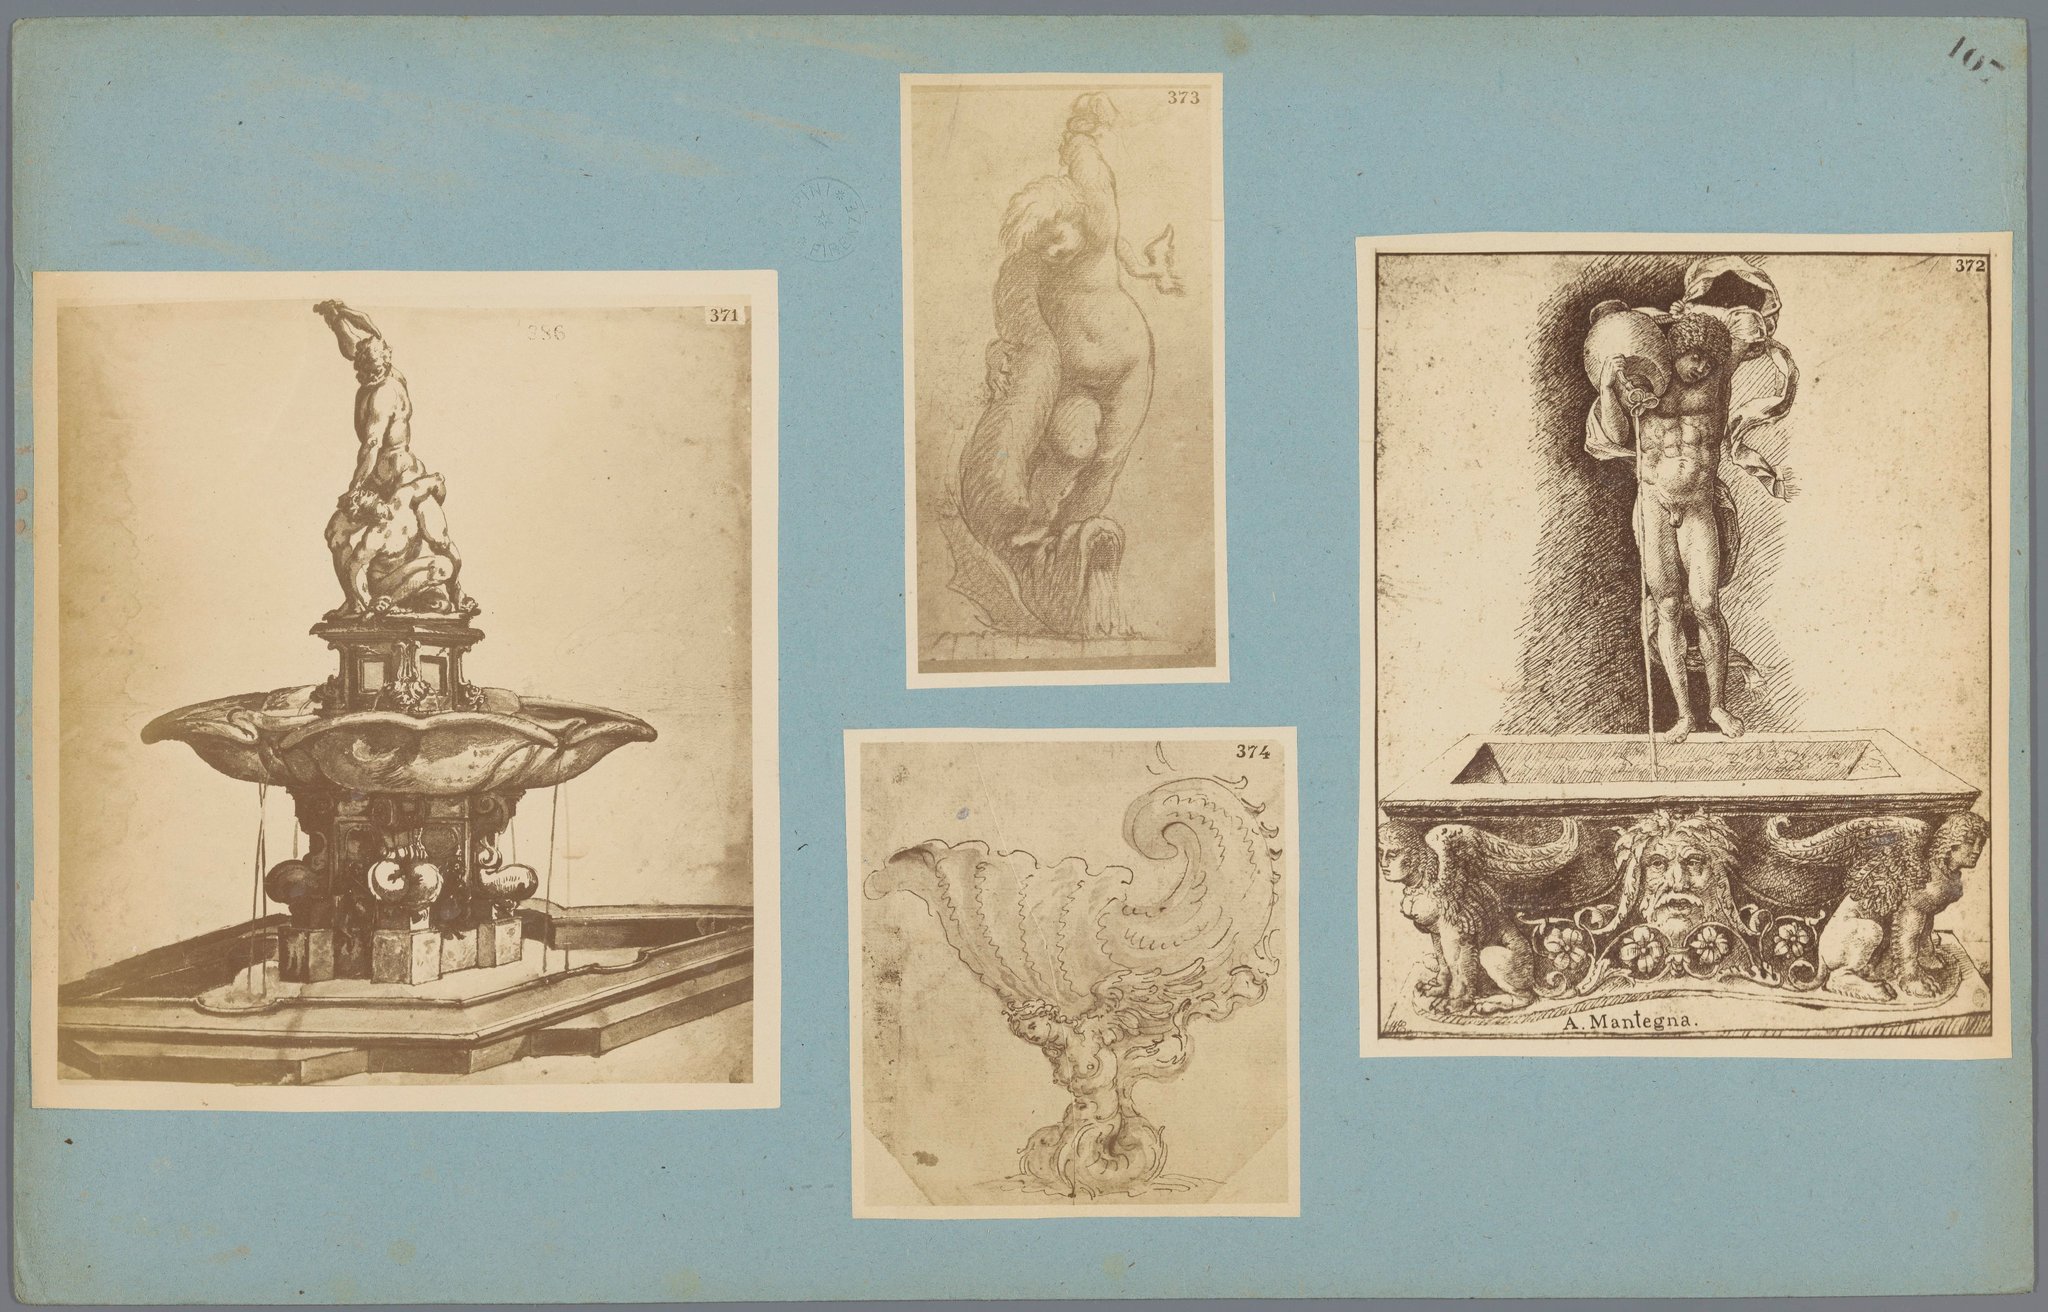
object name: photograph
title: Vier fotoreproducties van tekeningen van fonteinen en een schaal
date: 1875-1900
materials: cardboard, photographic support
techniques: albumen print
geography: europe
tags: drawing, sketch, fishes, scallop, shell ~ ornament, ornamental fountain, dish, plate, saucer, europe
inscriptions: number: ‘386’, collector's mark: Lugt 3937, number: ‘107’, number: ‘371’, number: ‘374’, number: ‘372’, name: ‘C. Pini Firenze’, number: ‘373’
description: Links (371) een fontein met een man in een aanvallende houding tegenover iemand onder hem, midden boven (373) een fontein met een kind en een vis, midden onder (374) een schaal in de vorm van een schelp ondersteund door een vrouwenfiguur, rechts (372) een fontein met een man die een waterkruik draagt door Andrea Mantegna.